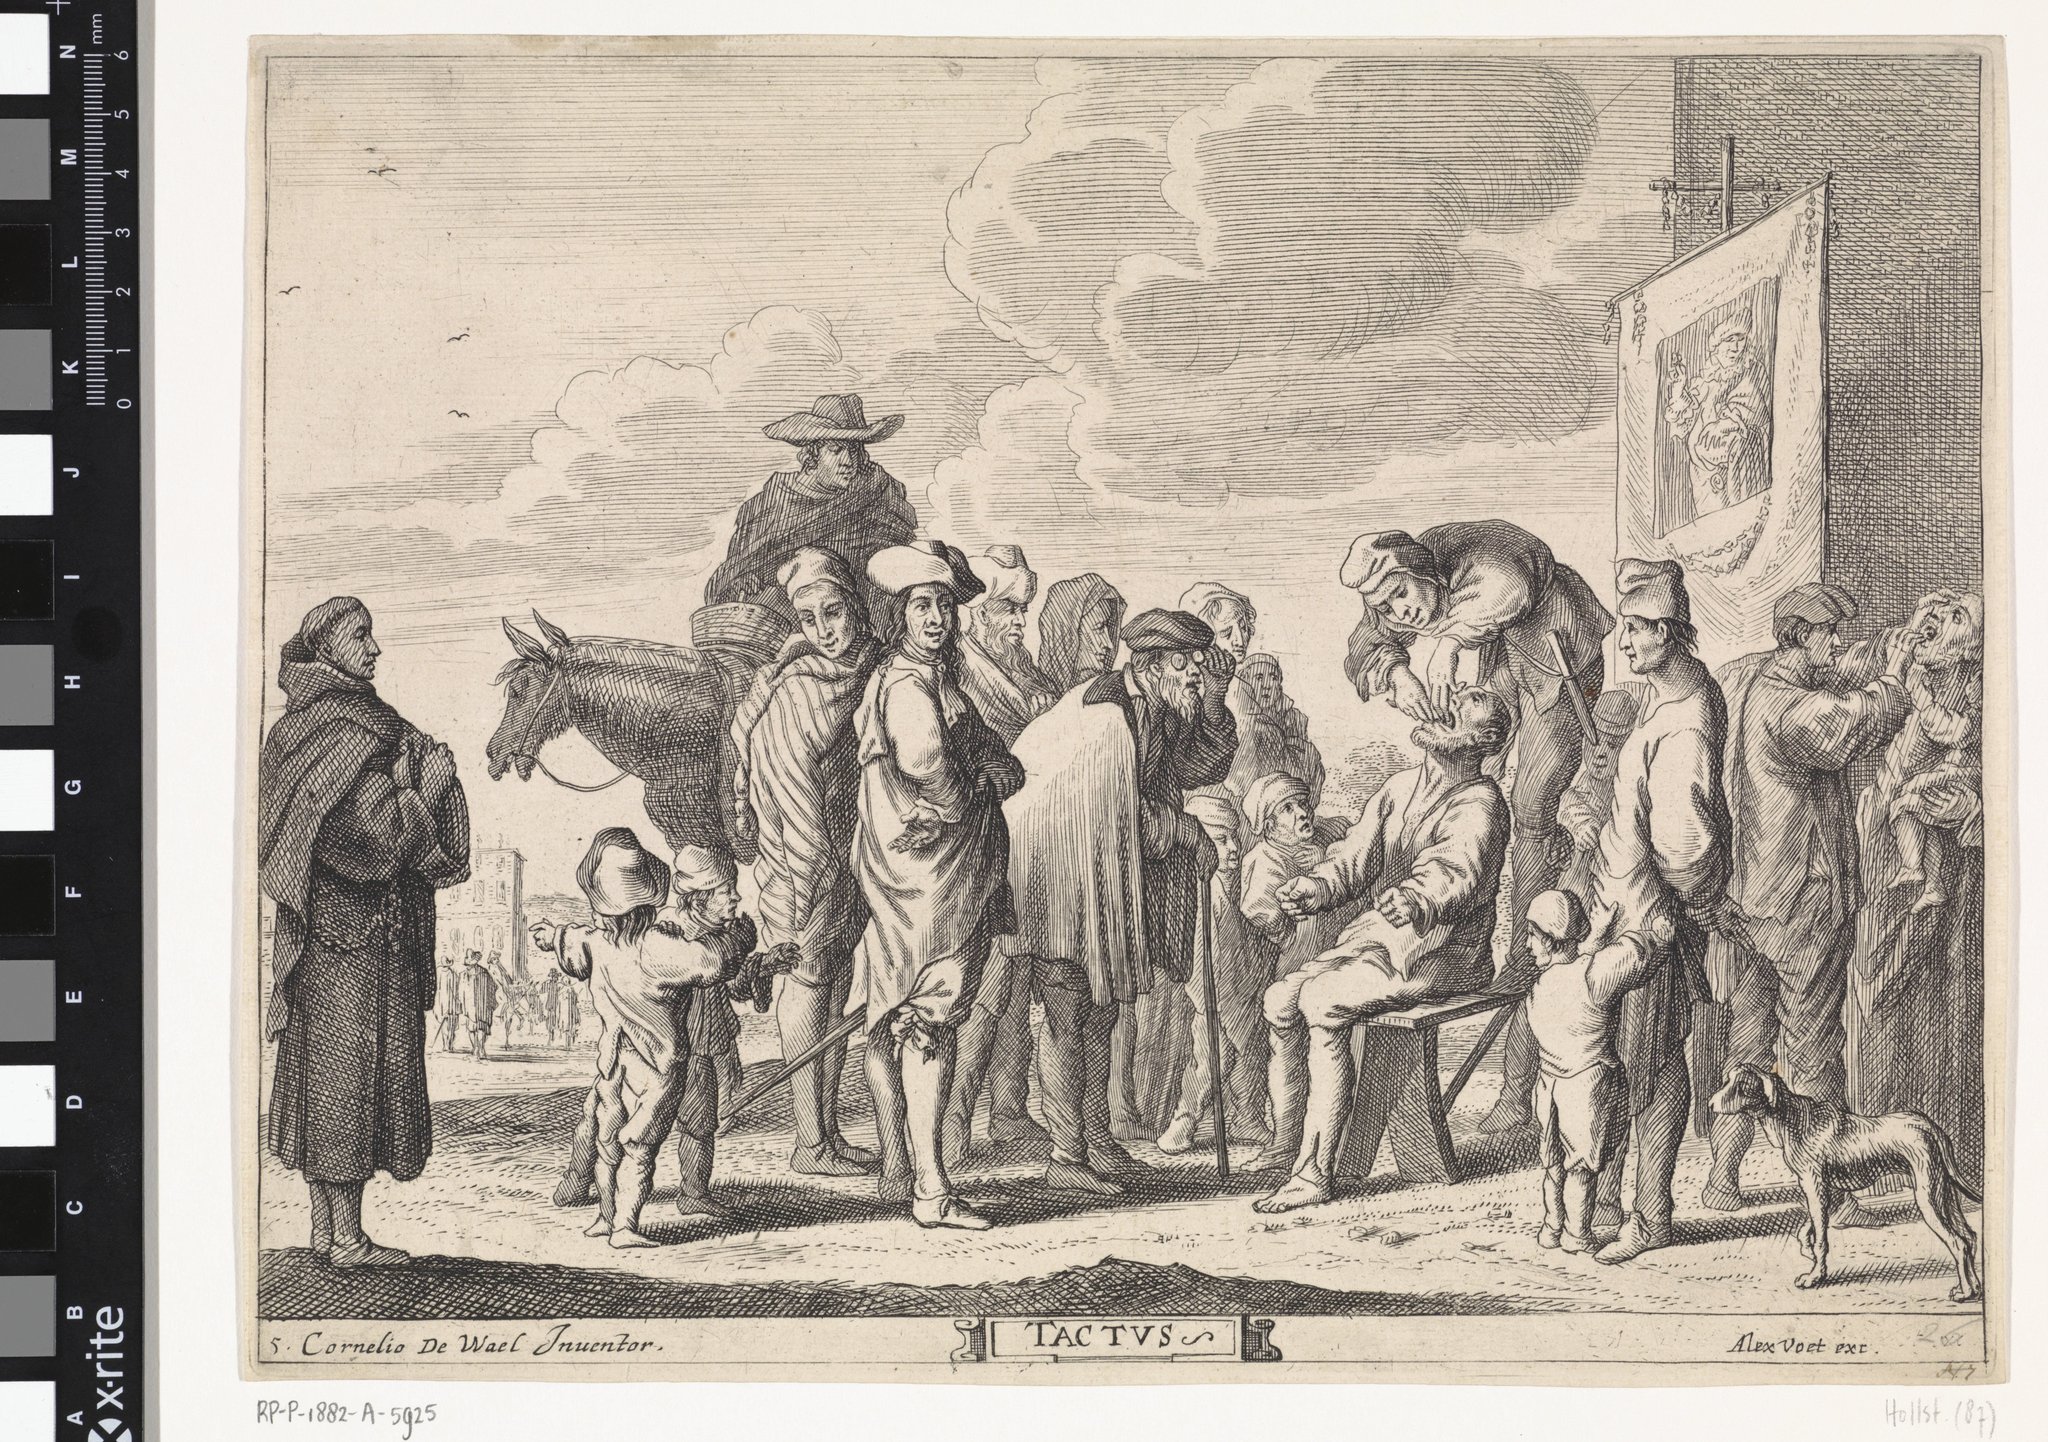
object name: print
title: Tactvs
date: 1628-1689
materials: paper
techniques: engraving, etching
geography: italy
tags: feeling (one of the five senses)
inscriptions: number: ‘N.1’, collector's mark: Lugt 2228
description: Een kwakzalver kijkt in de mond van een man. Een groep mensen heeft zich om hen heen verzameld. Links een monnik die toekijkt. Rechts een andere kwakzalver die in de mond van een vrouw kijkt.